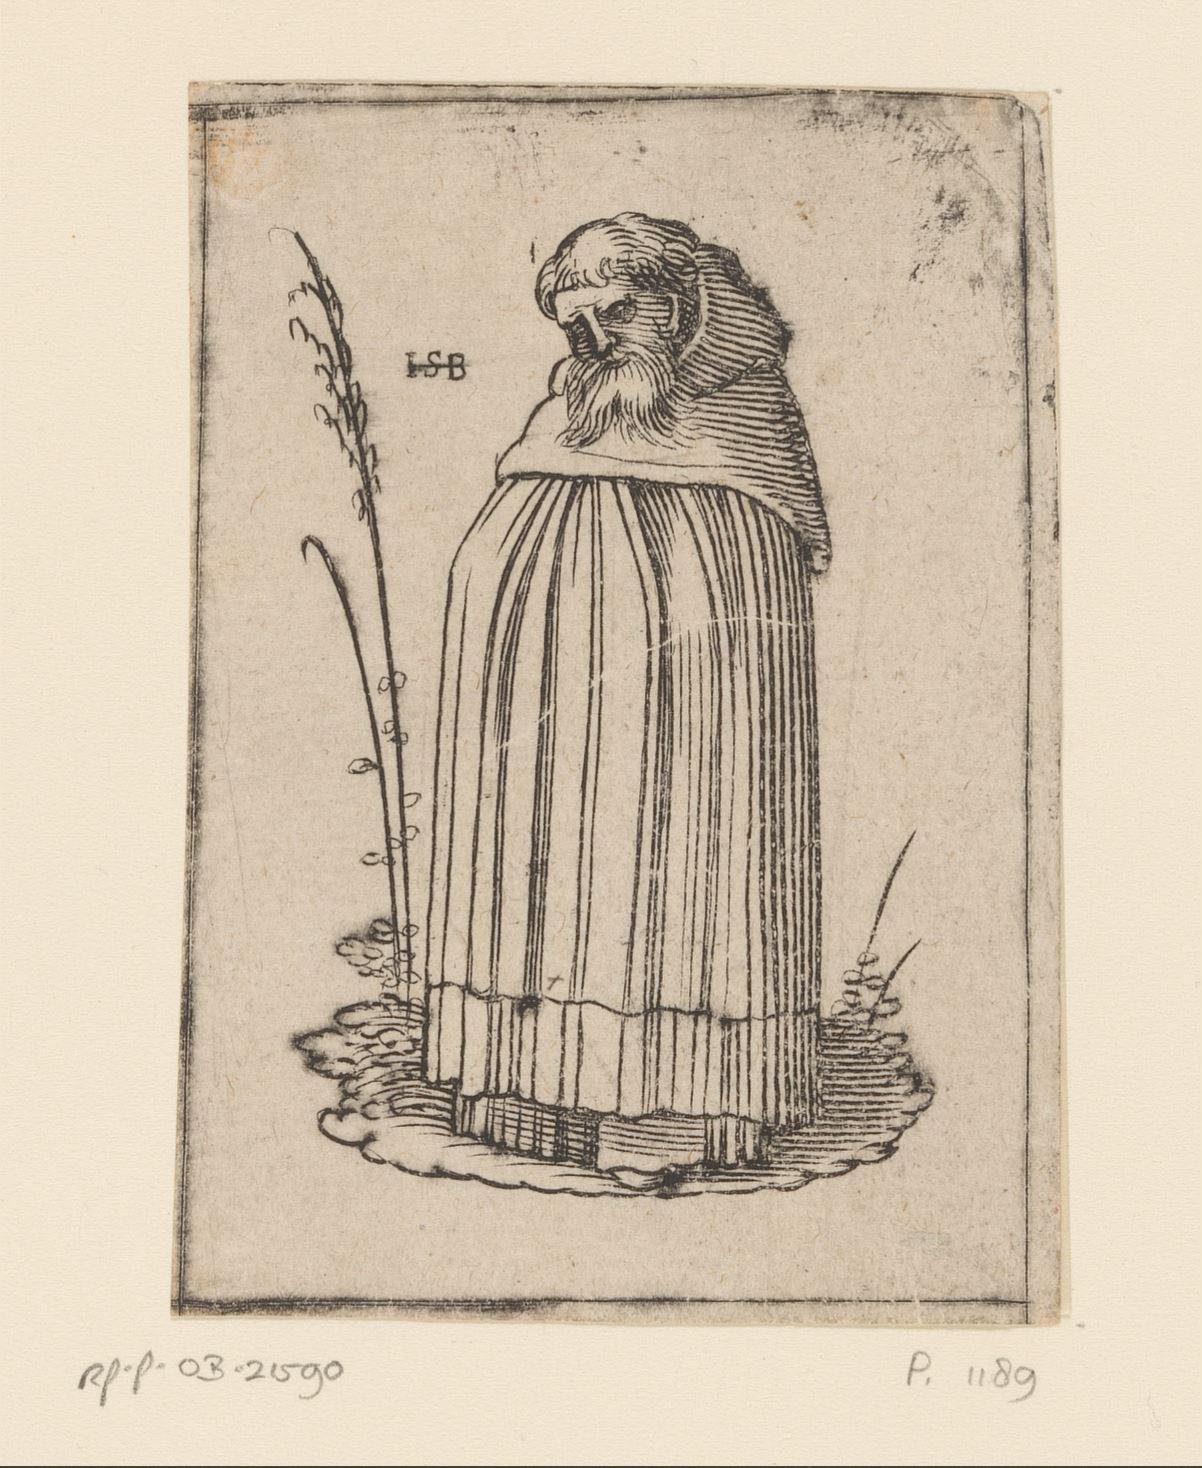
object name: print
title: Monnik uit Schotland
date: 1526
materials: paper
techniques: engraving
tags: liturgical vestments, canonicals, monastic orders, monastic life ~ roman catholic church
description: Onderdeel van een serie van 28 gegraveerde kopieën in de andere richting naar Hans Sebald Behams "Das Papstthum mit seinen Gliedern", 1526.